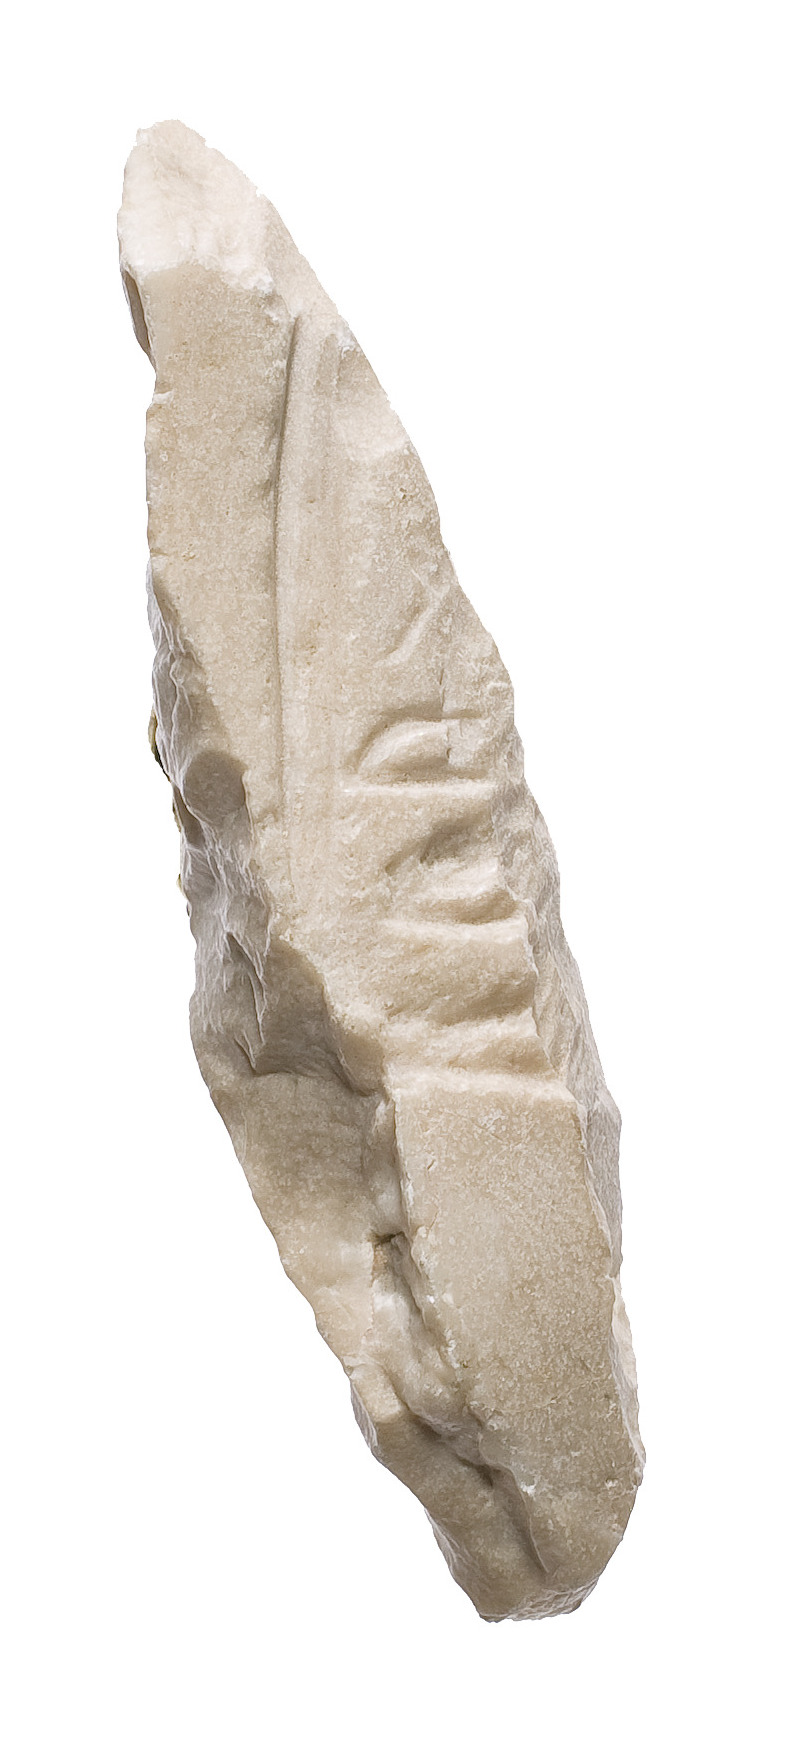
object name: fragment with aten cartouche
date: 1353-1336 BCE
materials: limestone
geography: egypt